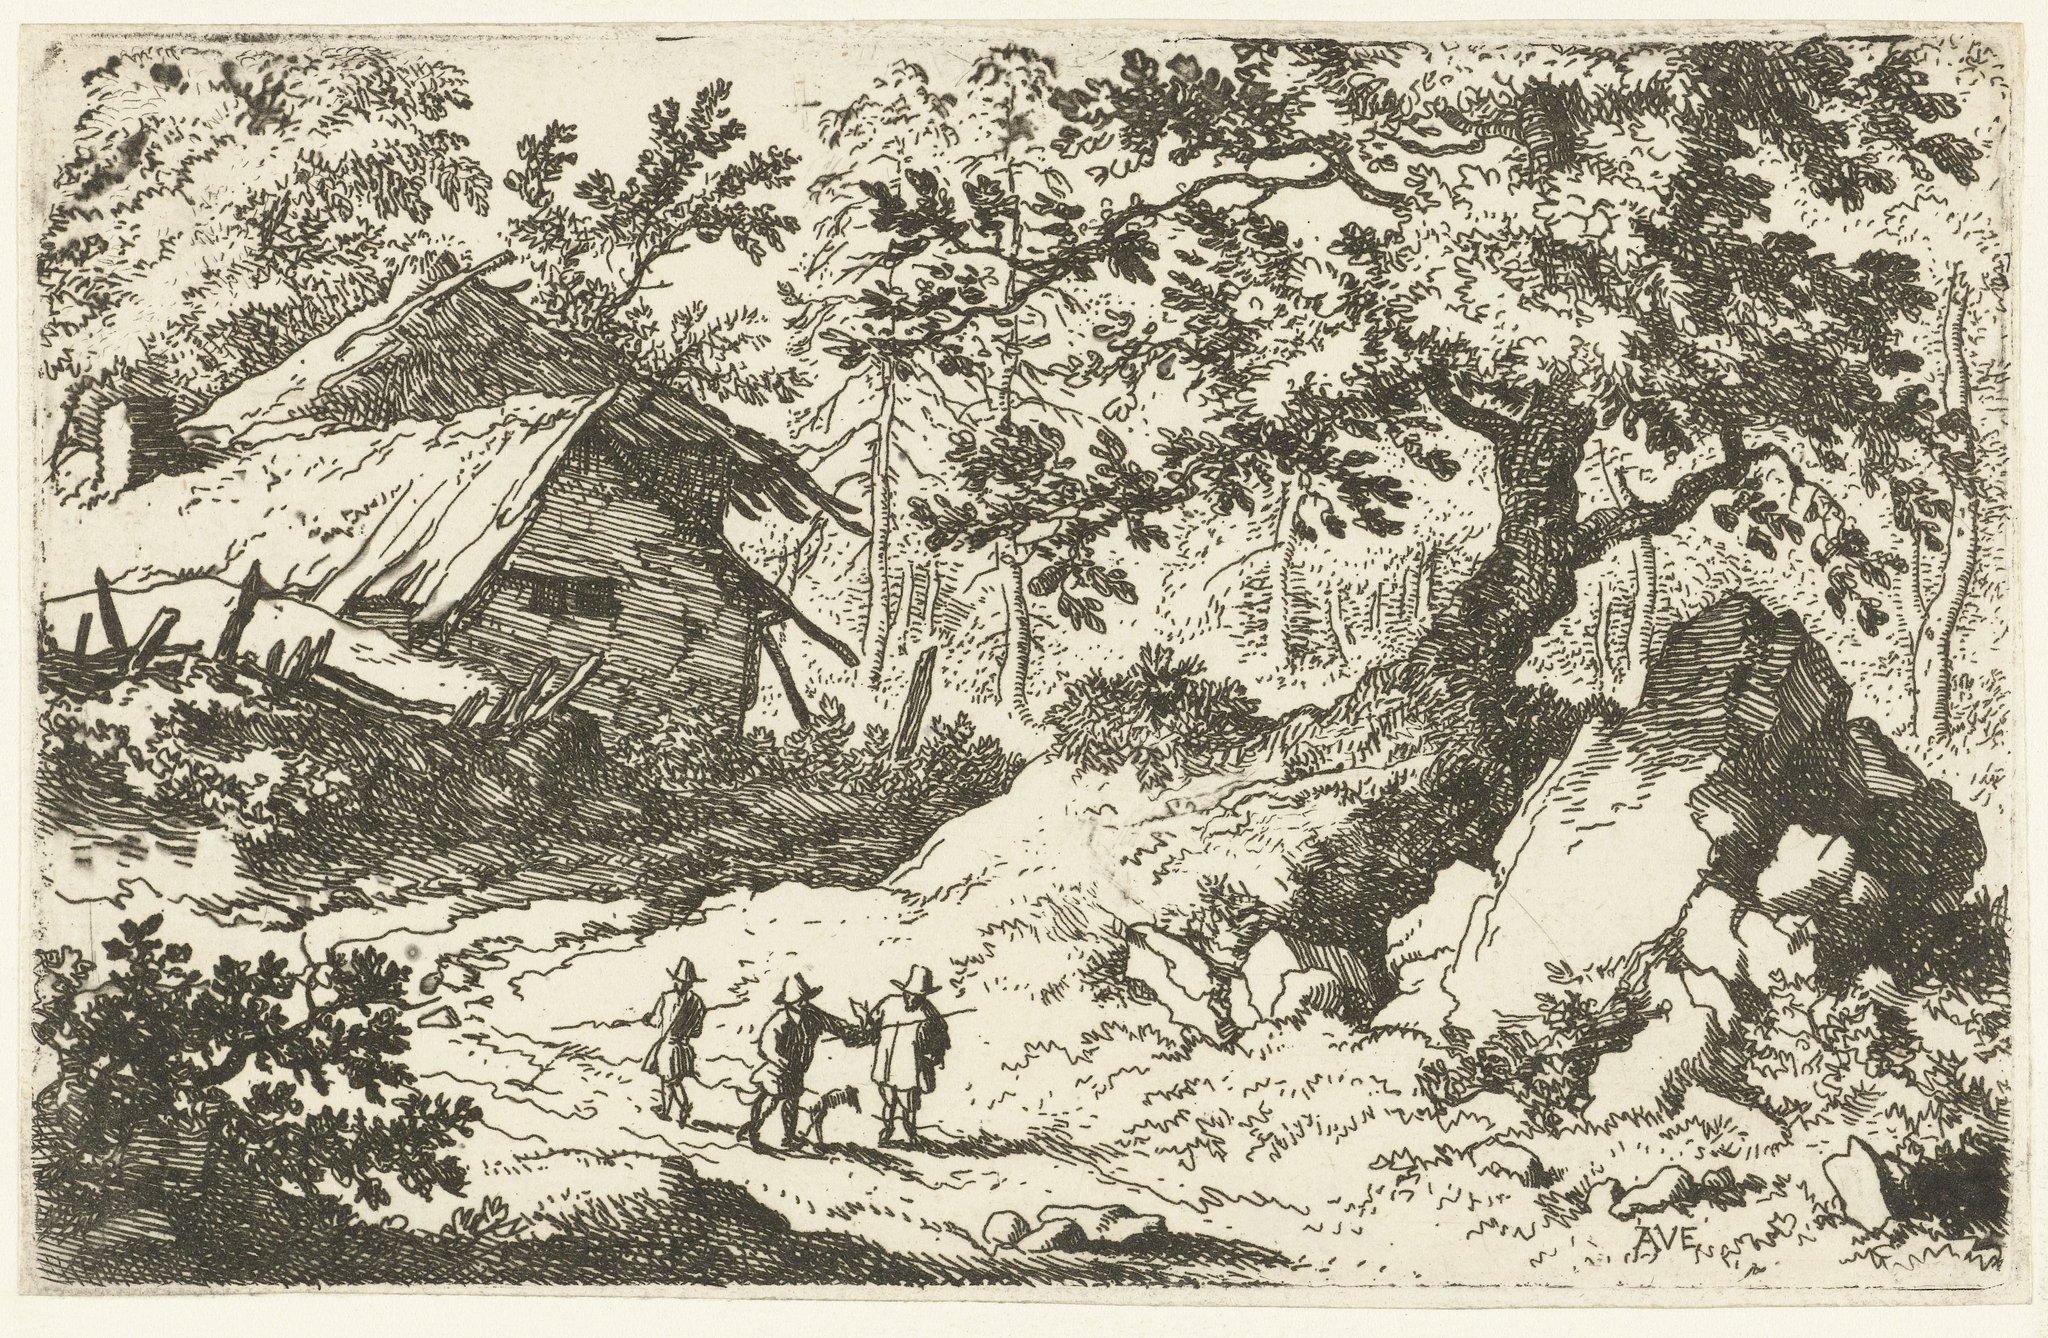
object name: print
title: Drie wandelaars bij een vervallen huis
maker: allaert van everdingen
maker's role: draughtsman, painter, print maker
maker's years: 1621-1675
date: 1631-1675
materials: paper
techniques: etching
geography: netherlands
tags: landscape with ruins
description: Landschap met drie personen en een hond op een pad bij een vervallen huis.